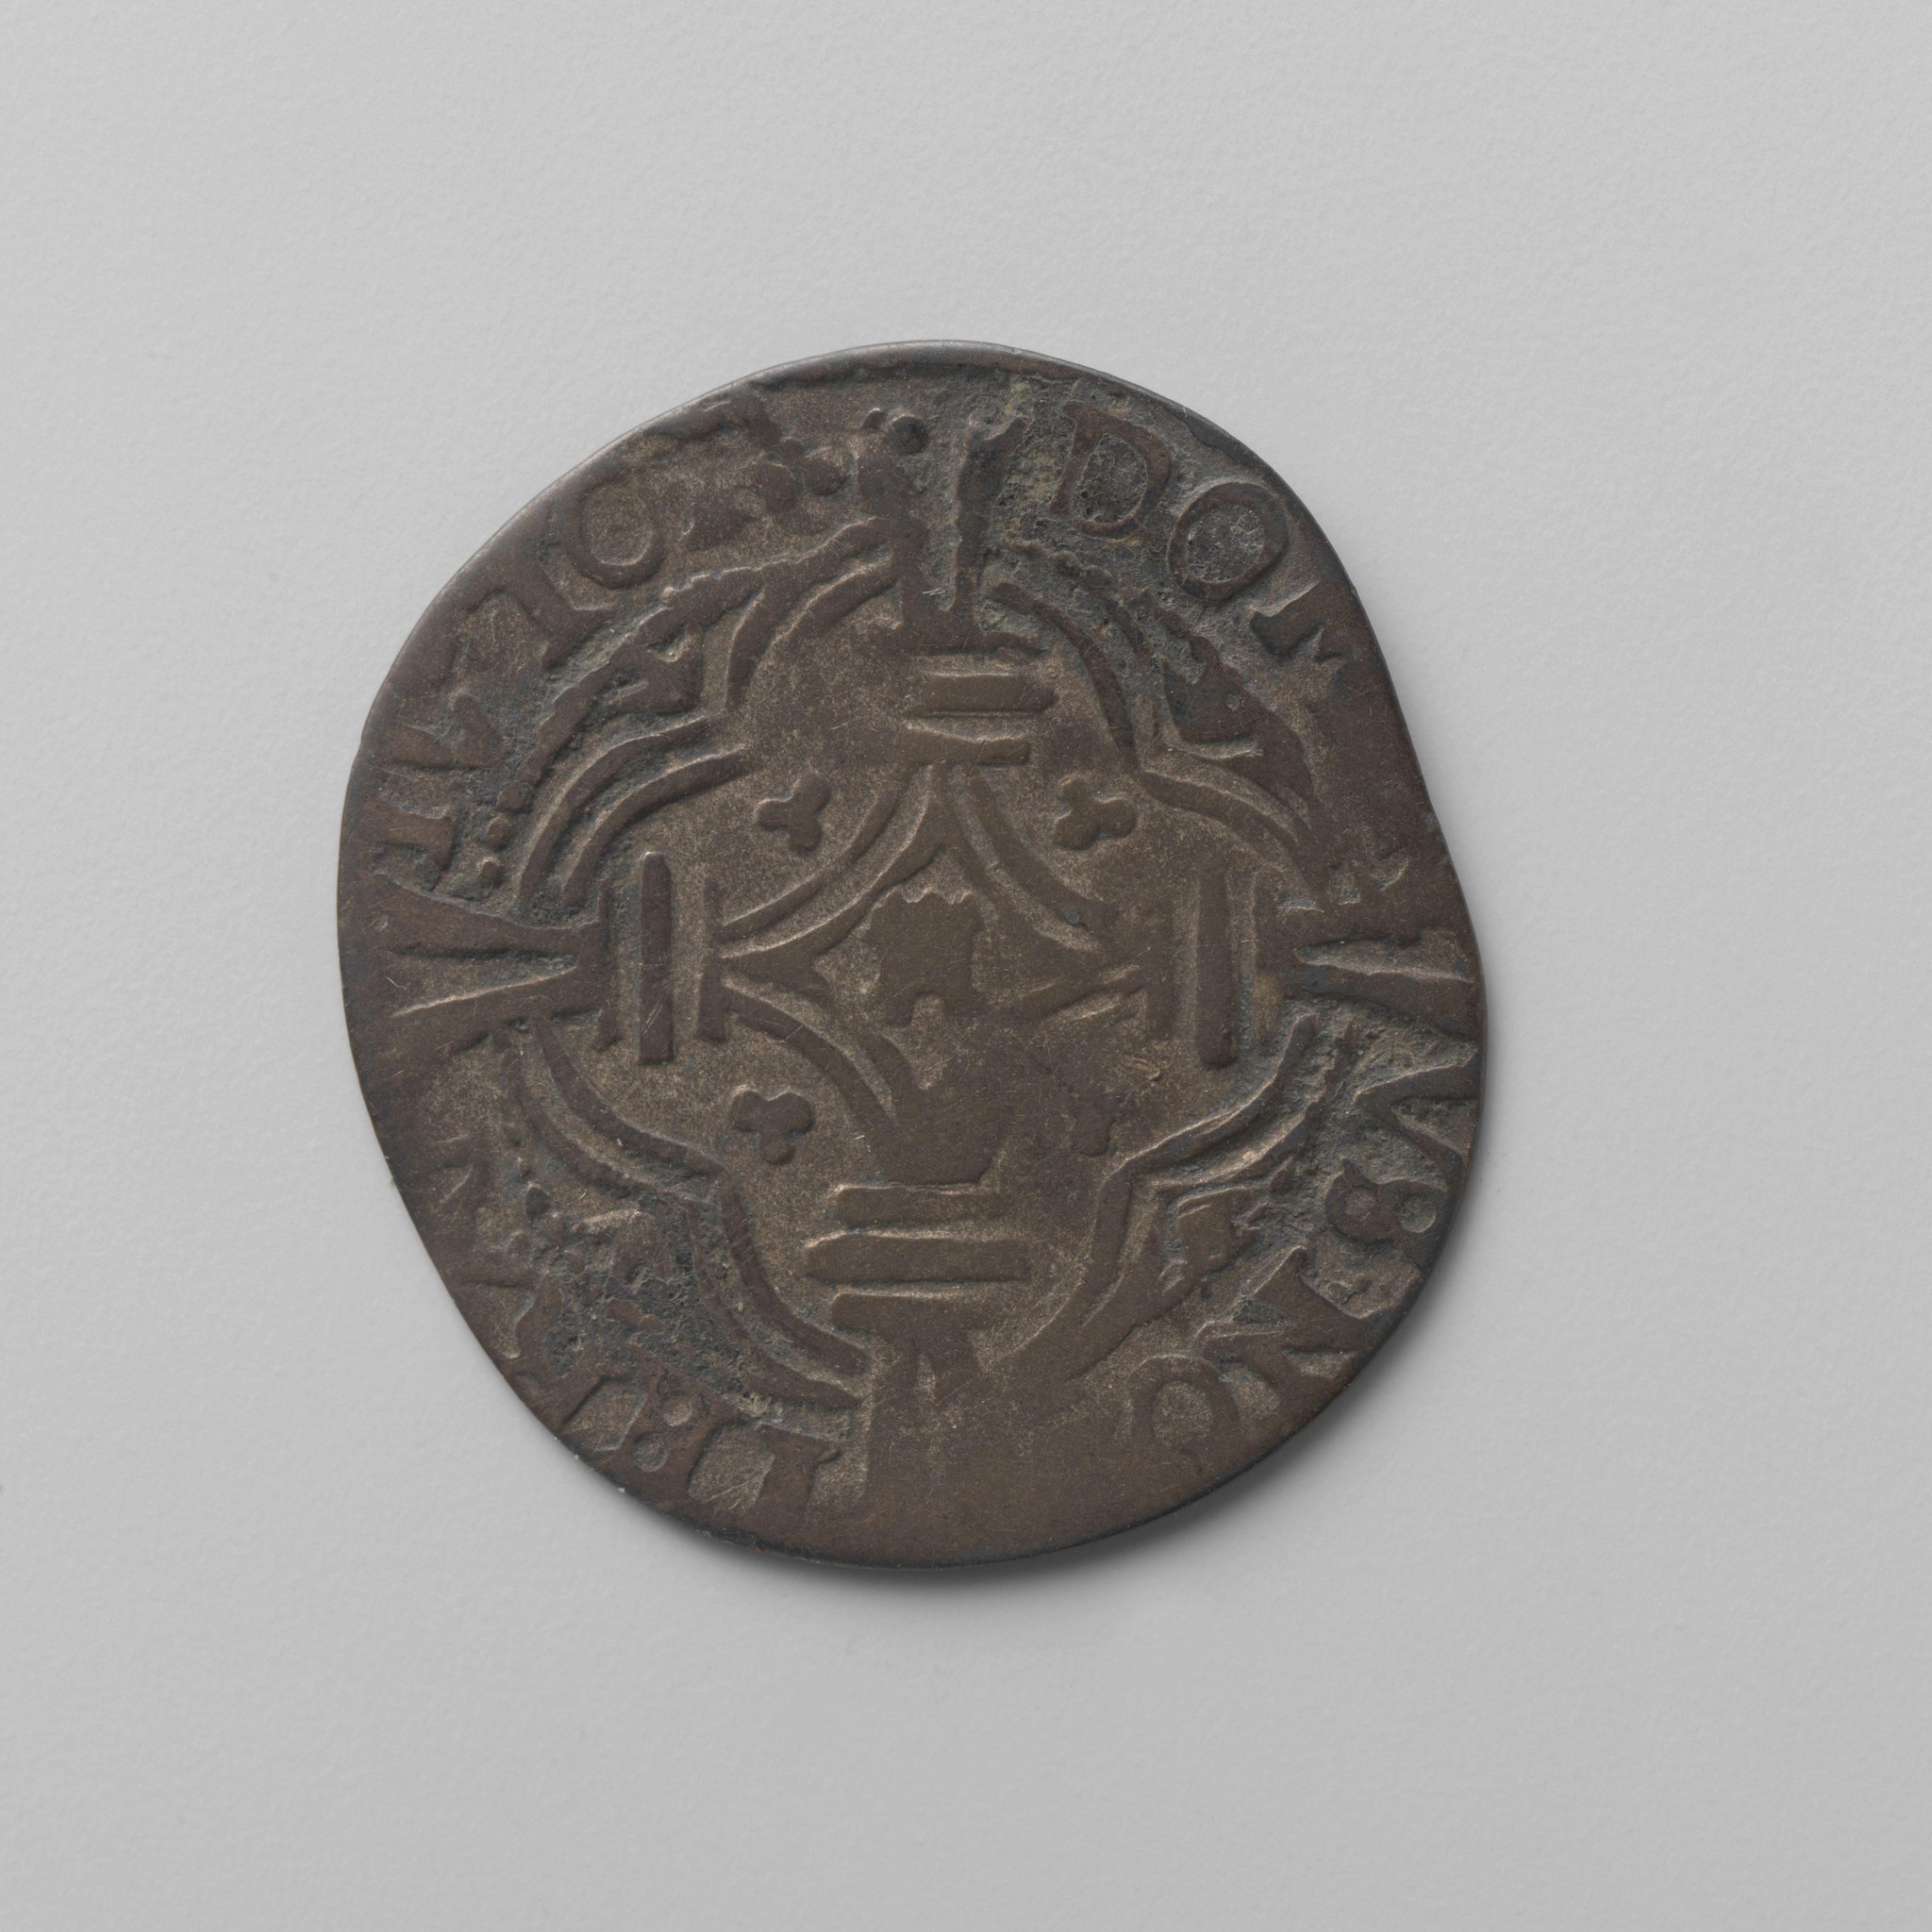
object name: coin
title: Stuiver van Kampen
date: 1590-1610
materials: silver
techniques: striking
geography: kampen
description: Zilveren munt. Voorzijde: tussen waarde-aanduiding I S gekroond vereenvoudigd Spaans wapenschild. Keerzijde: op dubbellijnige vierpas lang gevoet kruis met in het centrum een kleine roos. In de hoeken kleine klaverbladen.